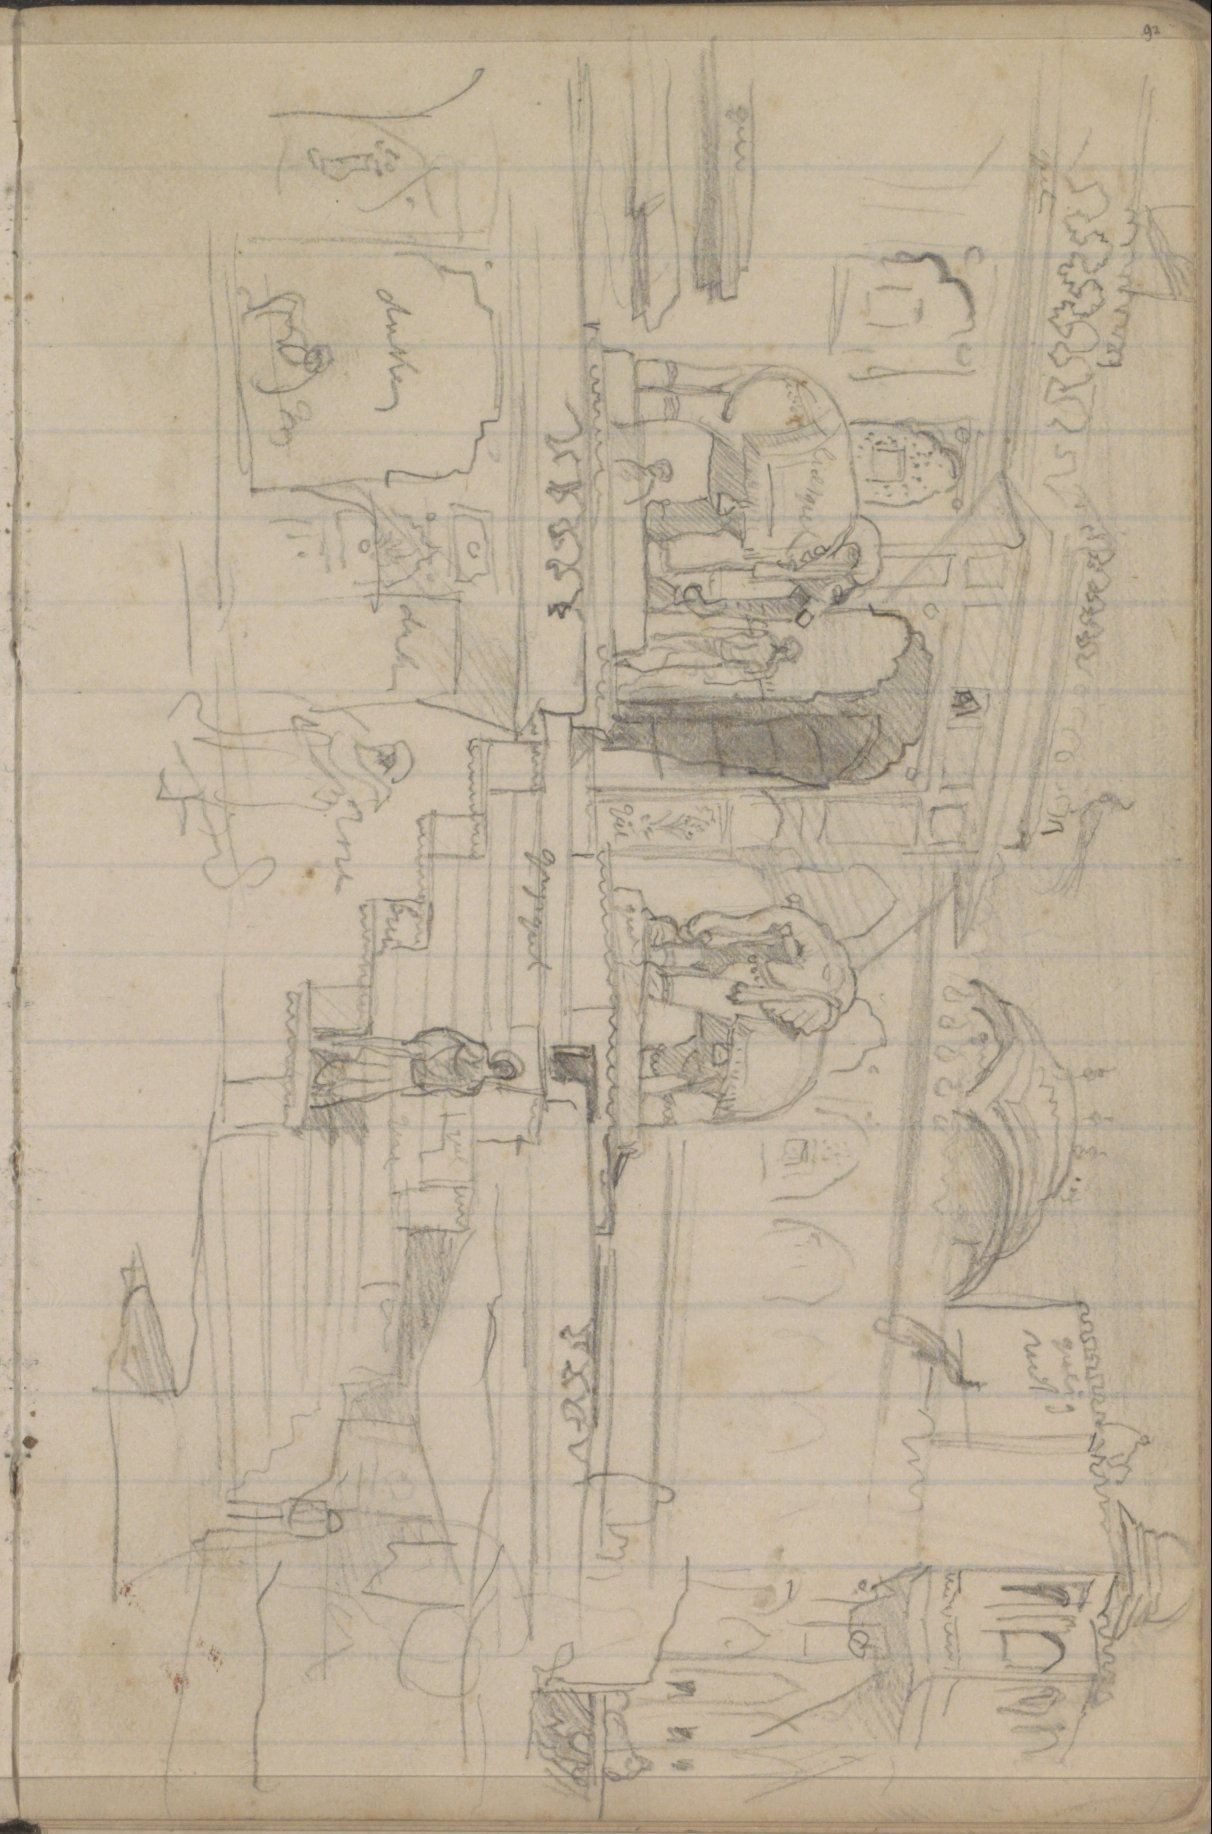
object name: sketchbook leaf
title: Portaal met beeldhouwwerken van olifanten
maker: marius bauer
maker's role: draughtsman, print maker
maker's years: 1867-1932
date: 1897-1898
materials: pencil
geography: jaipur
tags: flight of steps, arch, archivolt ~ architecture, sculpture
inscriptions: kleurnotitie, handgeschreven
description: Mogelijk het portaal en de trappen van een tempel. Pagina 92 uit een schetsboek met 84 bladen.